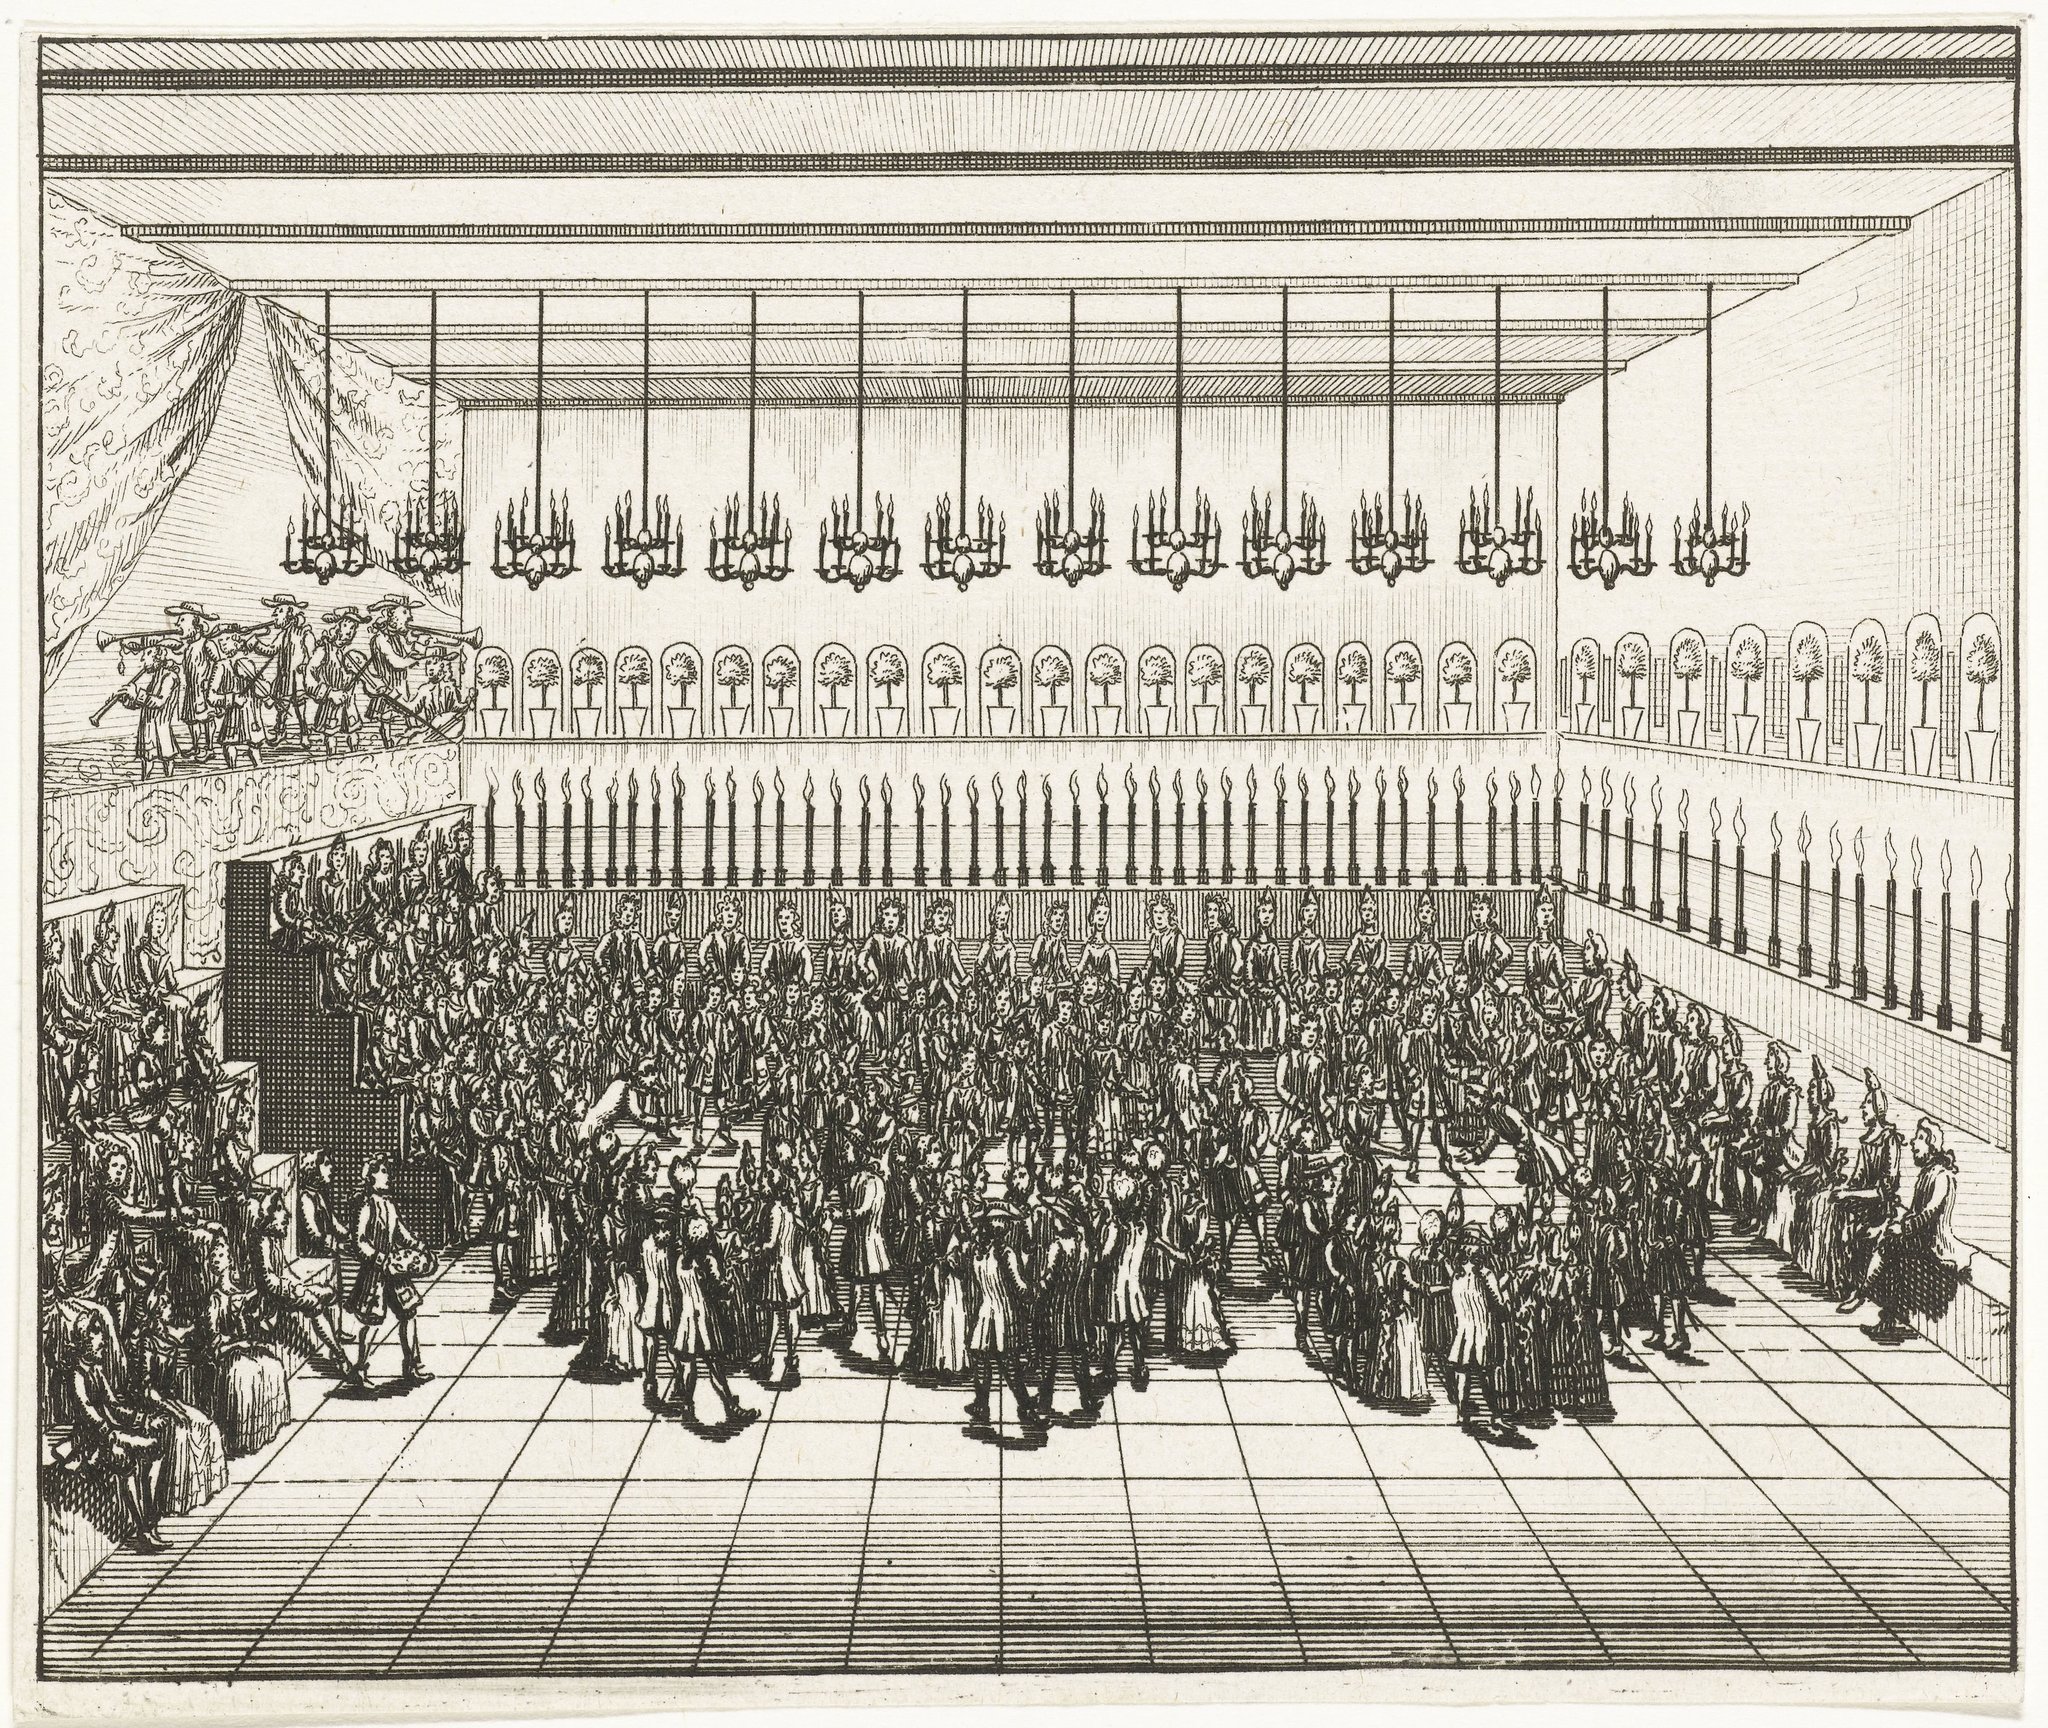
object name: print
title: Bal, 1714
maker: Anonymous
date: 1714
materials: paper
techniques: etching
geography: northern netherlands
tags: vienna, public festivities at birth of royal persons, ball, formal dance, utrecht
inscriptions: collector's mark: Lugt 2228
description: Een bal in een zaal versierd met kaarsen en potplanten, 1714. Onderdeel van een groep van twaalf illustraties van de feestelijkheden georganiseerd in Utrecht in 1714 door de Portugese graaf Joao Gomes da Silva conde de Tarouca ter ere van de geboorte van twee Portugese prinsjes van koning Johan V.